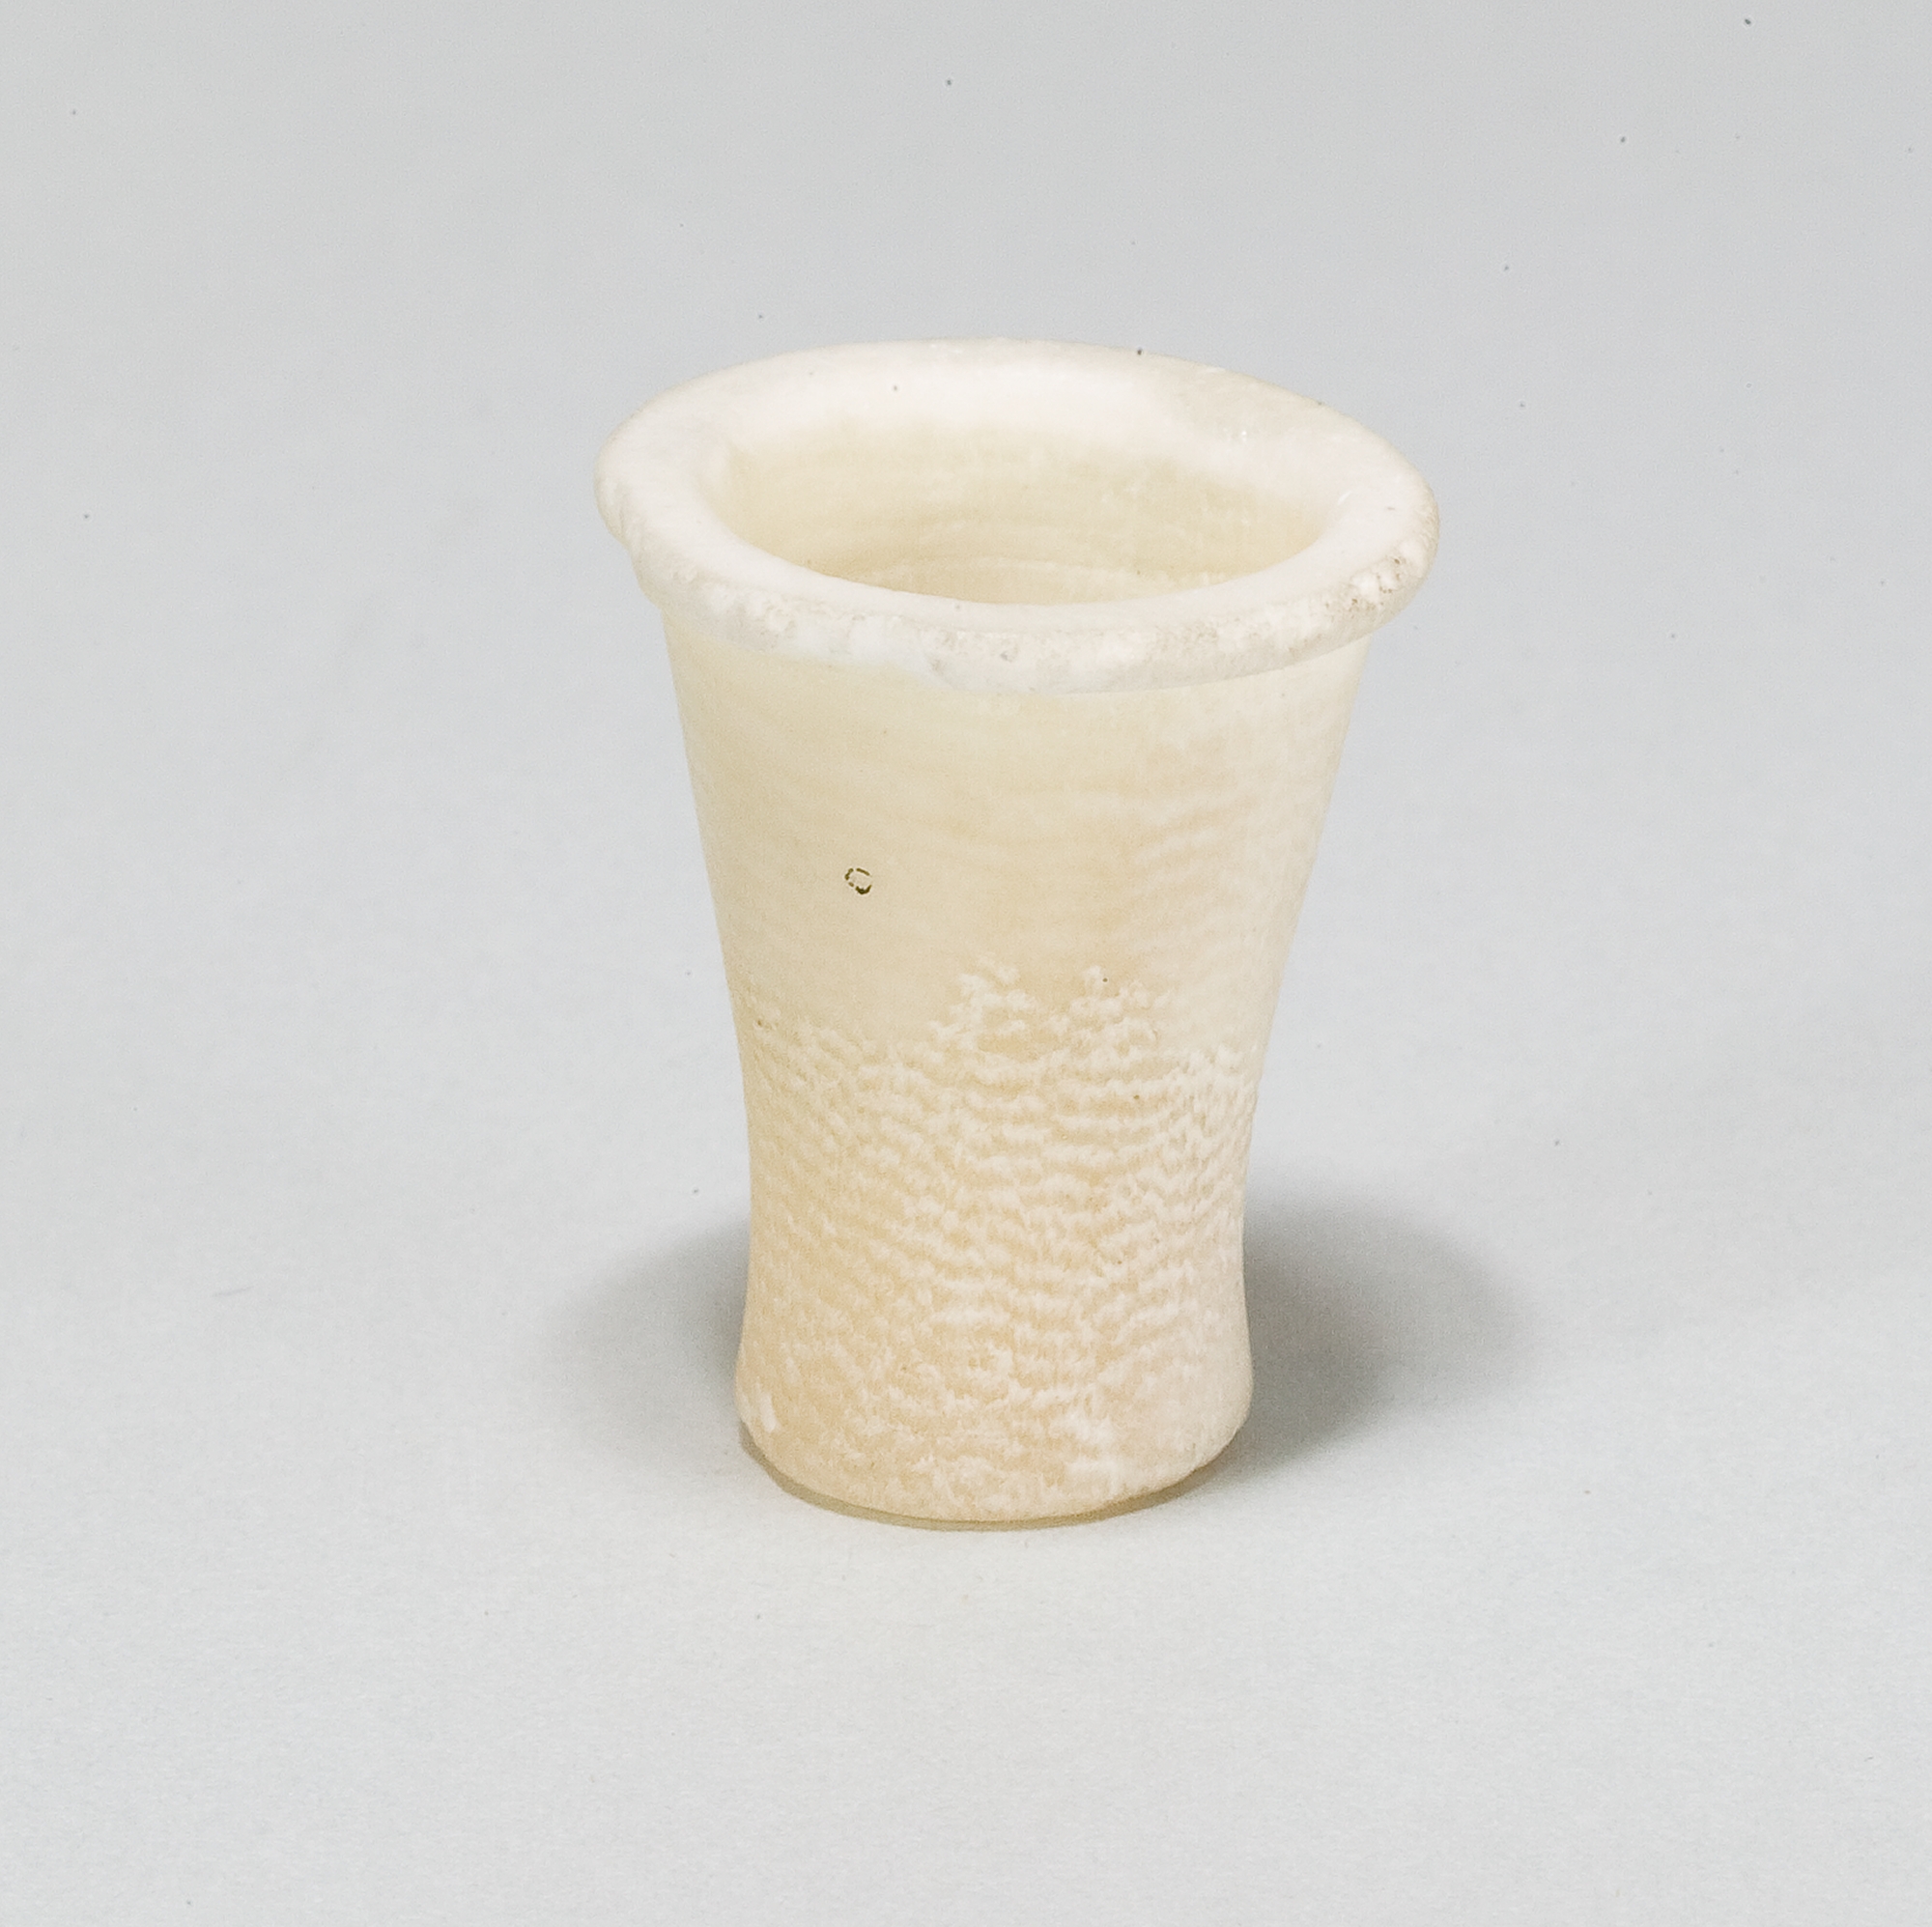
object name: ointment jar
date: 1850-1640 BCE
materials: stone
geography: egypt